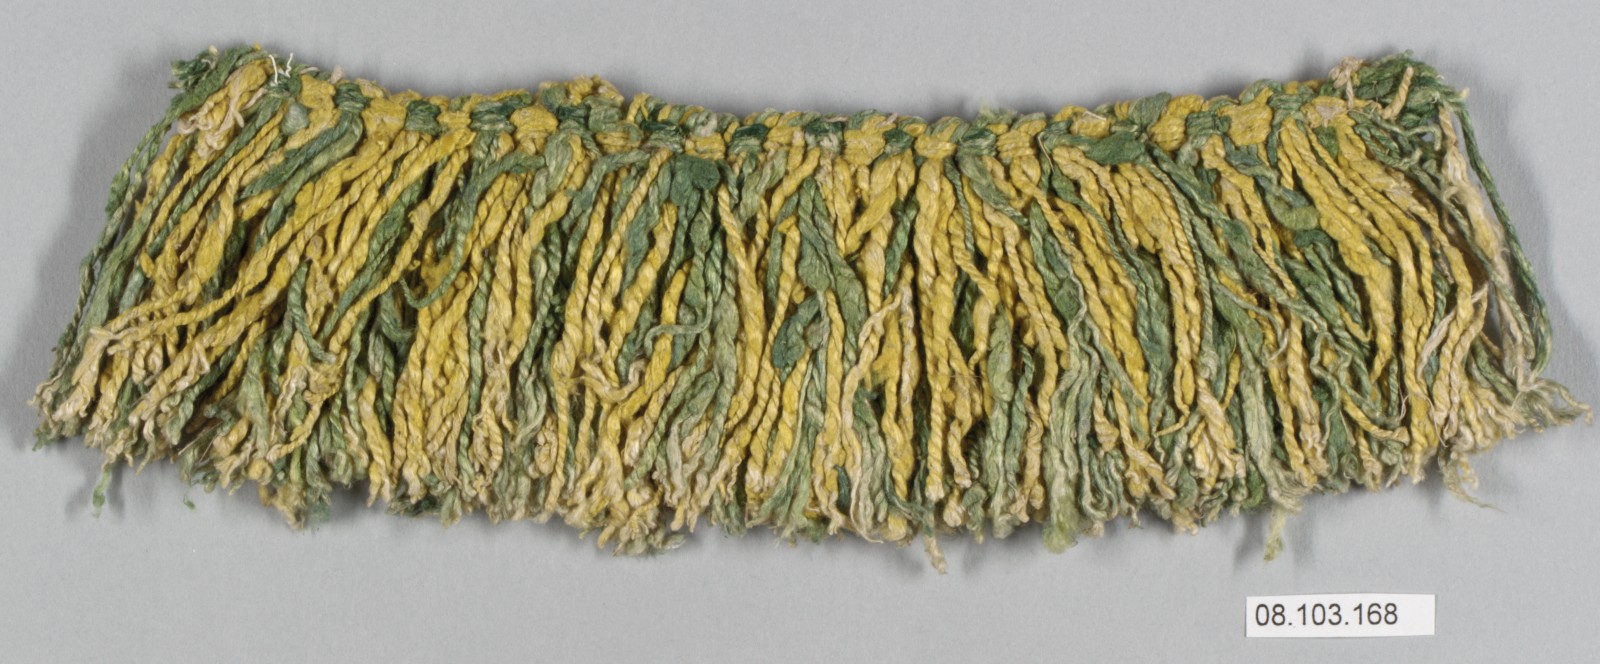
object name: fringe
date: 1601-1800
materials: cotton